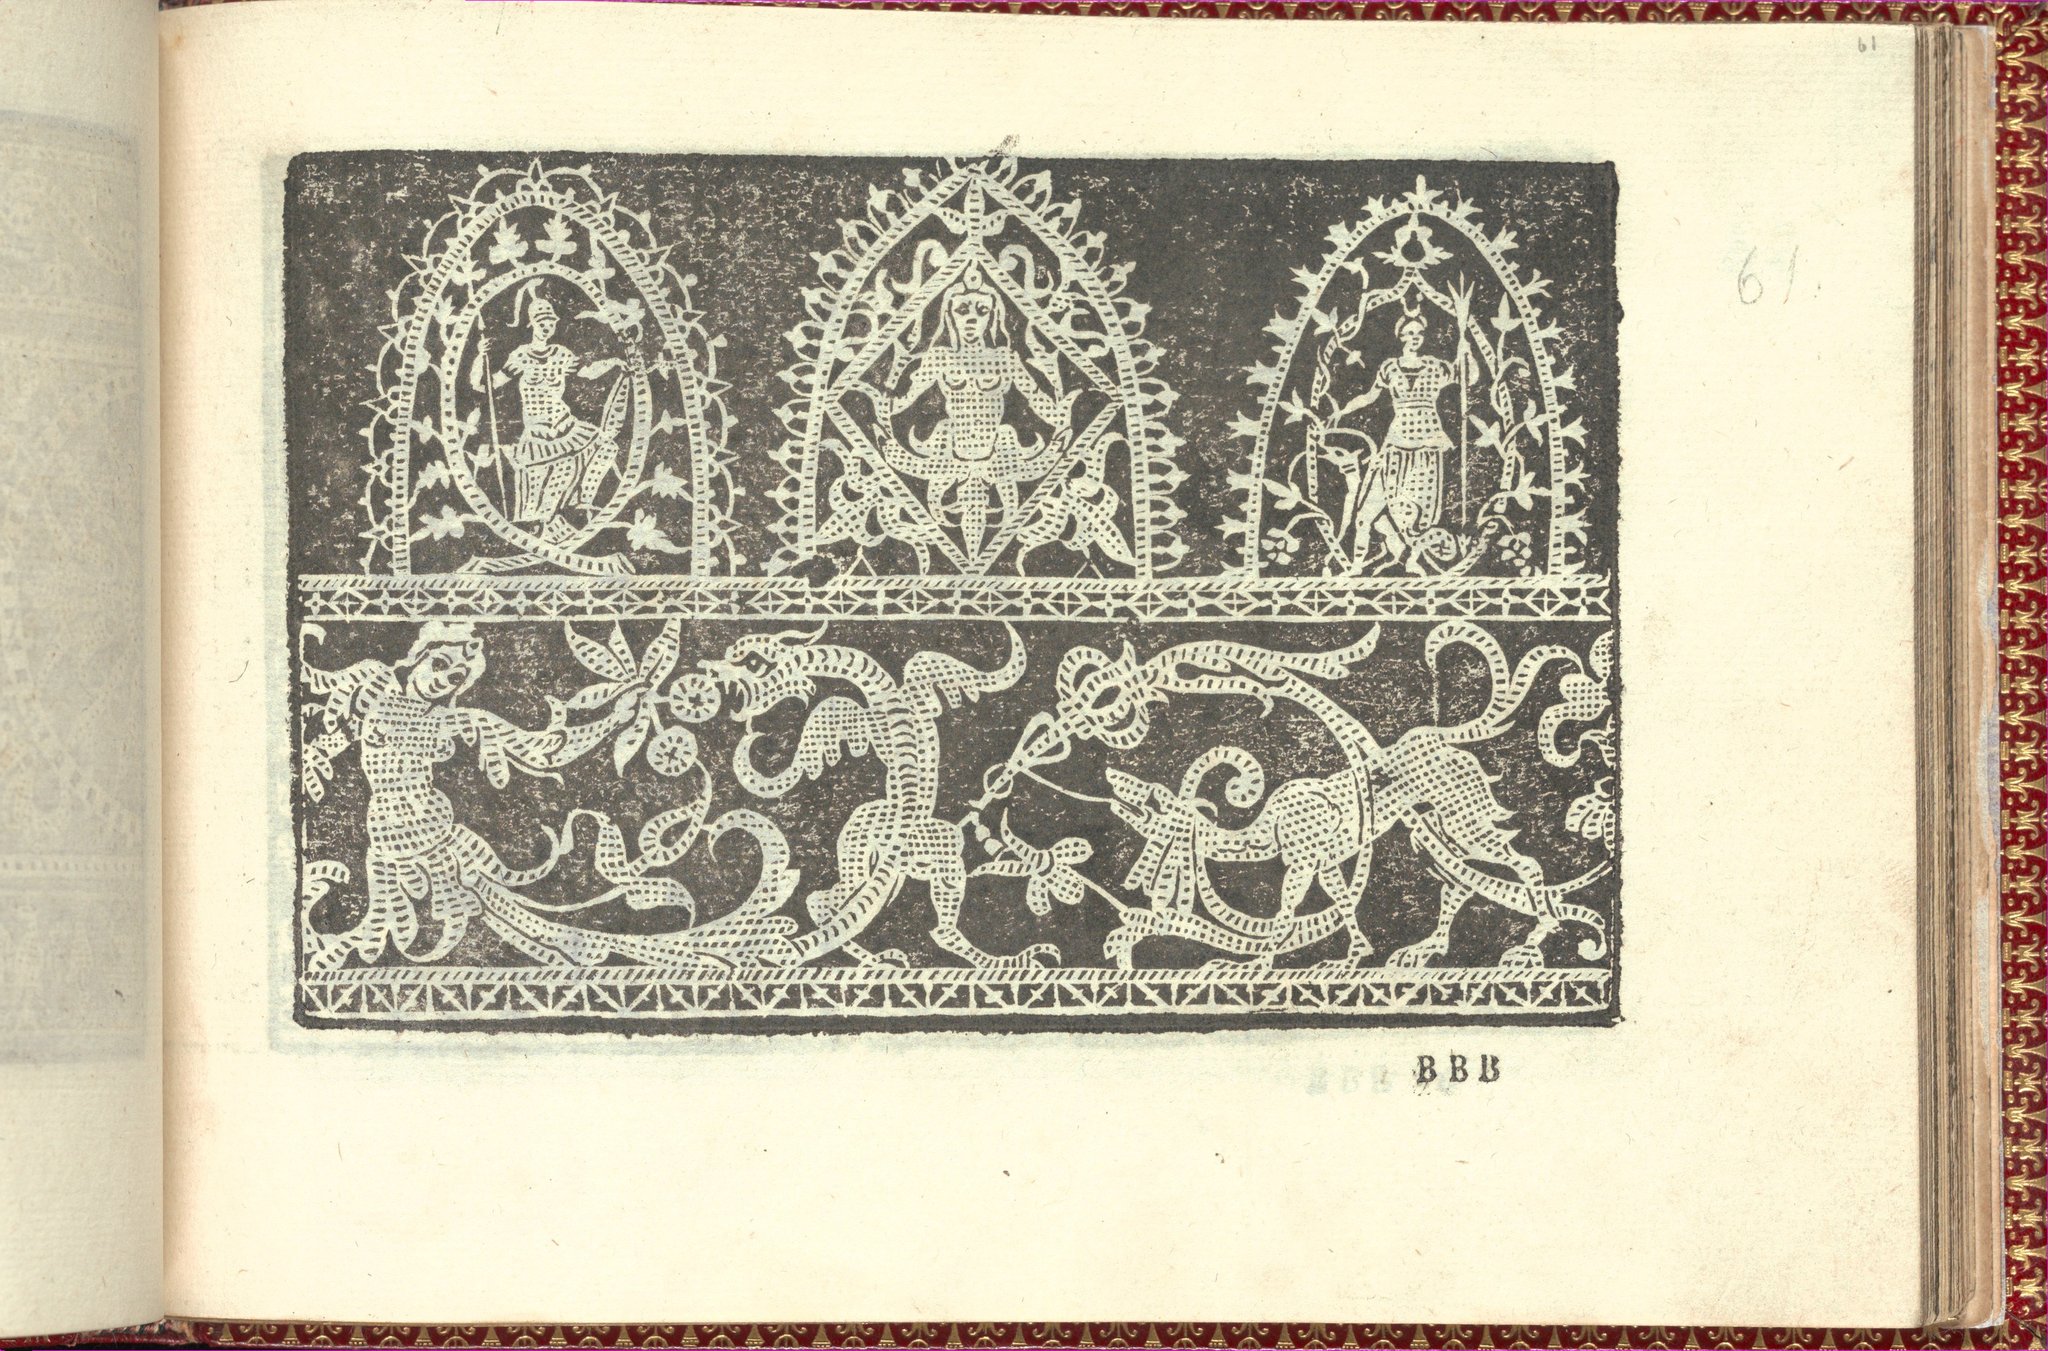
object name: book print ornament architecture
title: Corona delle Nobili et Virtuose Donne: Libro I-IV, page 61 (recto)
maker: cesare vecellio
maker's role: publisher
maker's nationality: italian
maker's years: 1521-1601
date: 1601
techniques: woodcut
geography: italy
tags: men